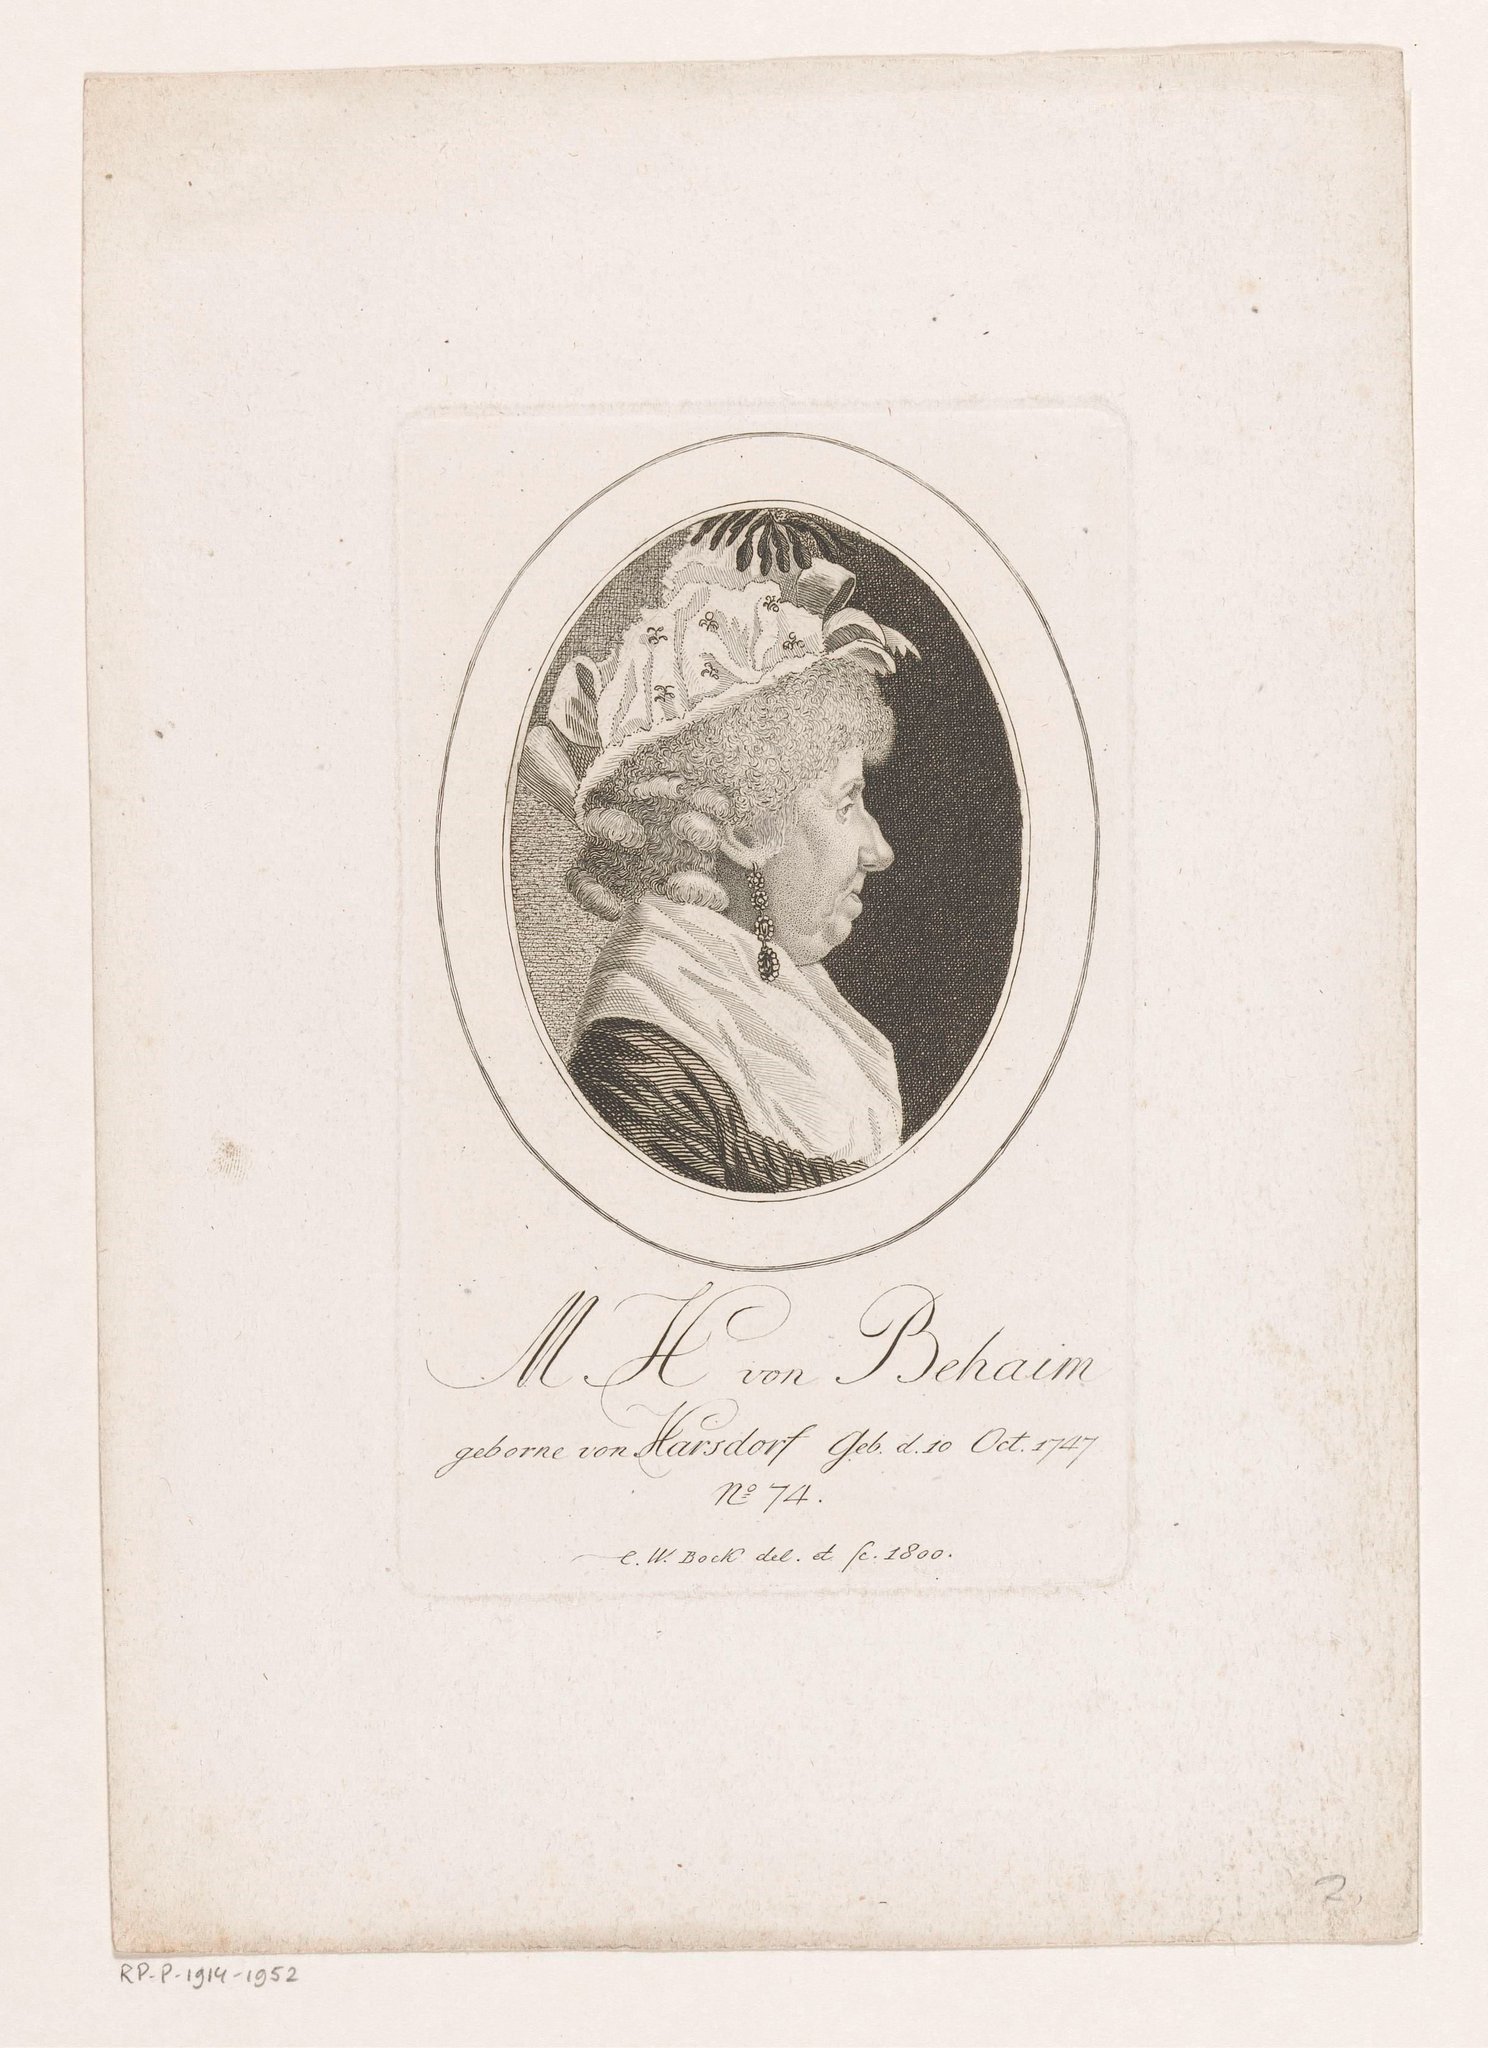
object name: print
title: Portret van Maria Helena Behaim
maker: christoph wilhelm bock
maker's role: print maker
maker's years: 1755-1836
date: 1800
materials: paper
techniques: engraving, etching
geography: nuremberg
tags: historical persons - bb - woman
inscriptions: collector's mark: Lugt 2228